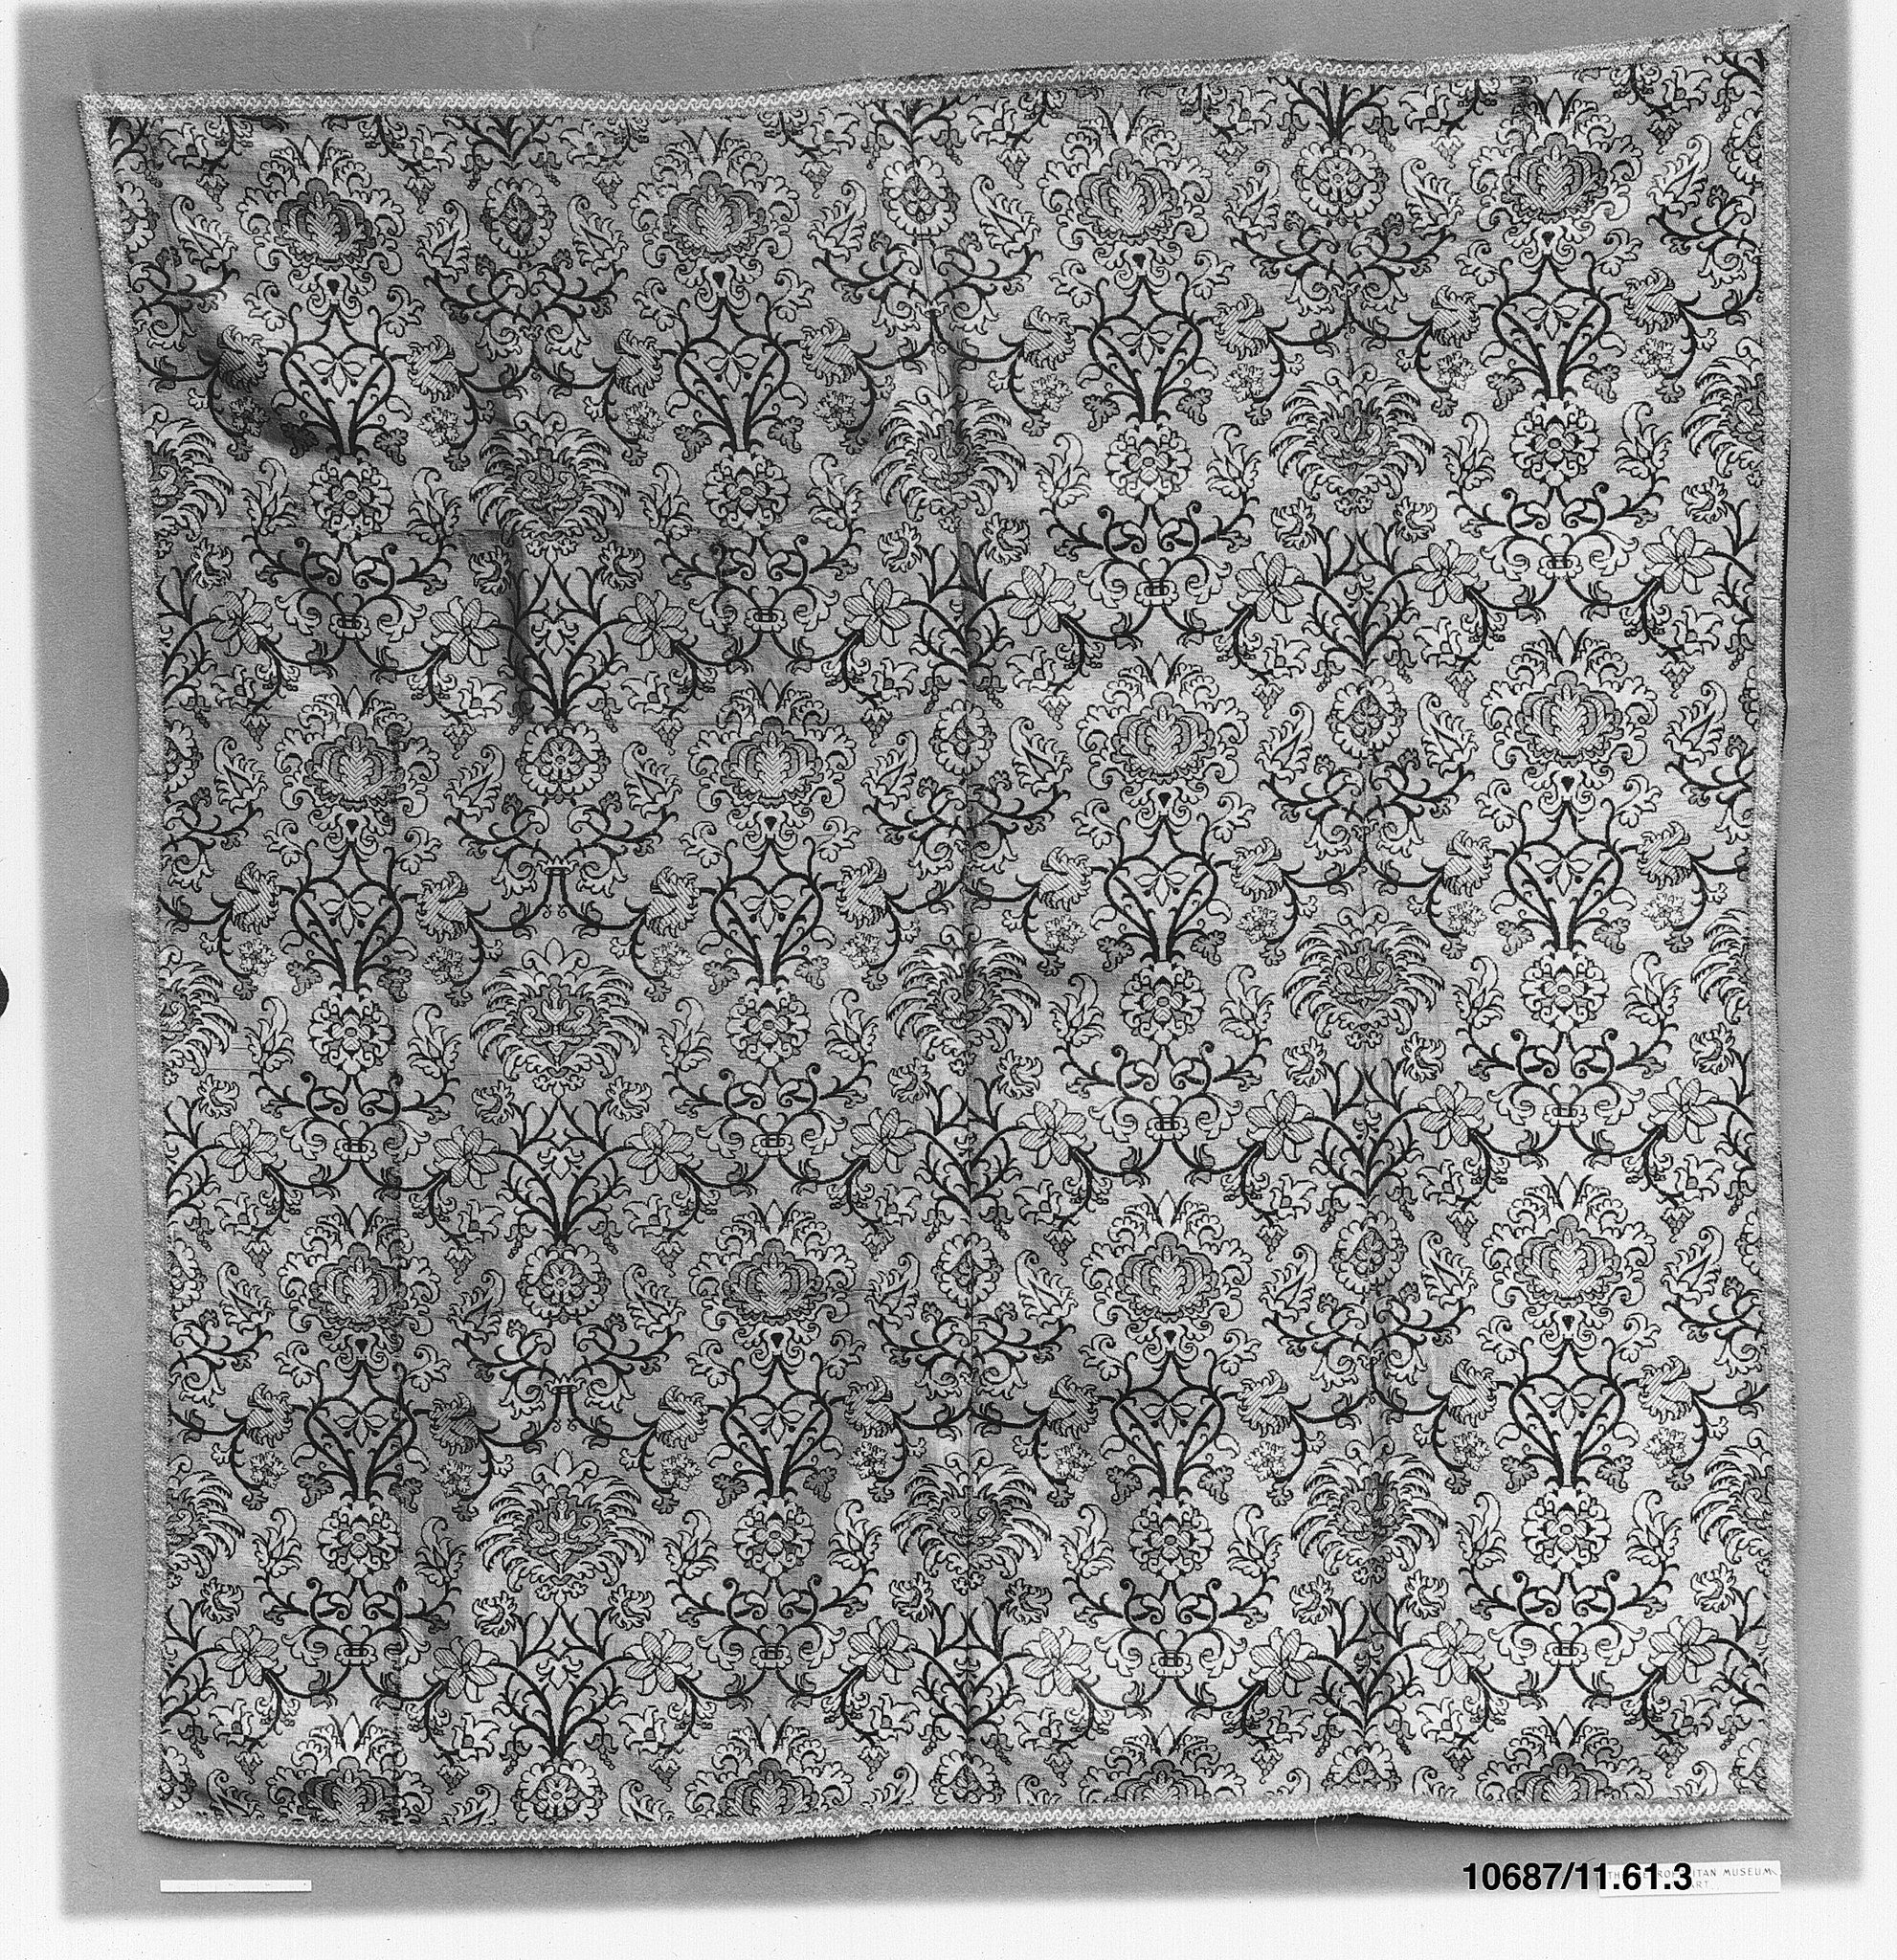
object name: piece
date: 1650-1670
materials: metal thread, silk